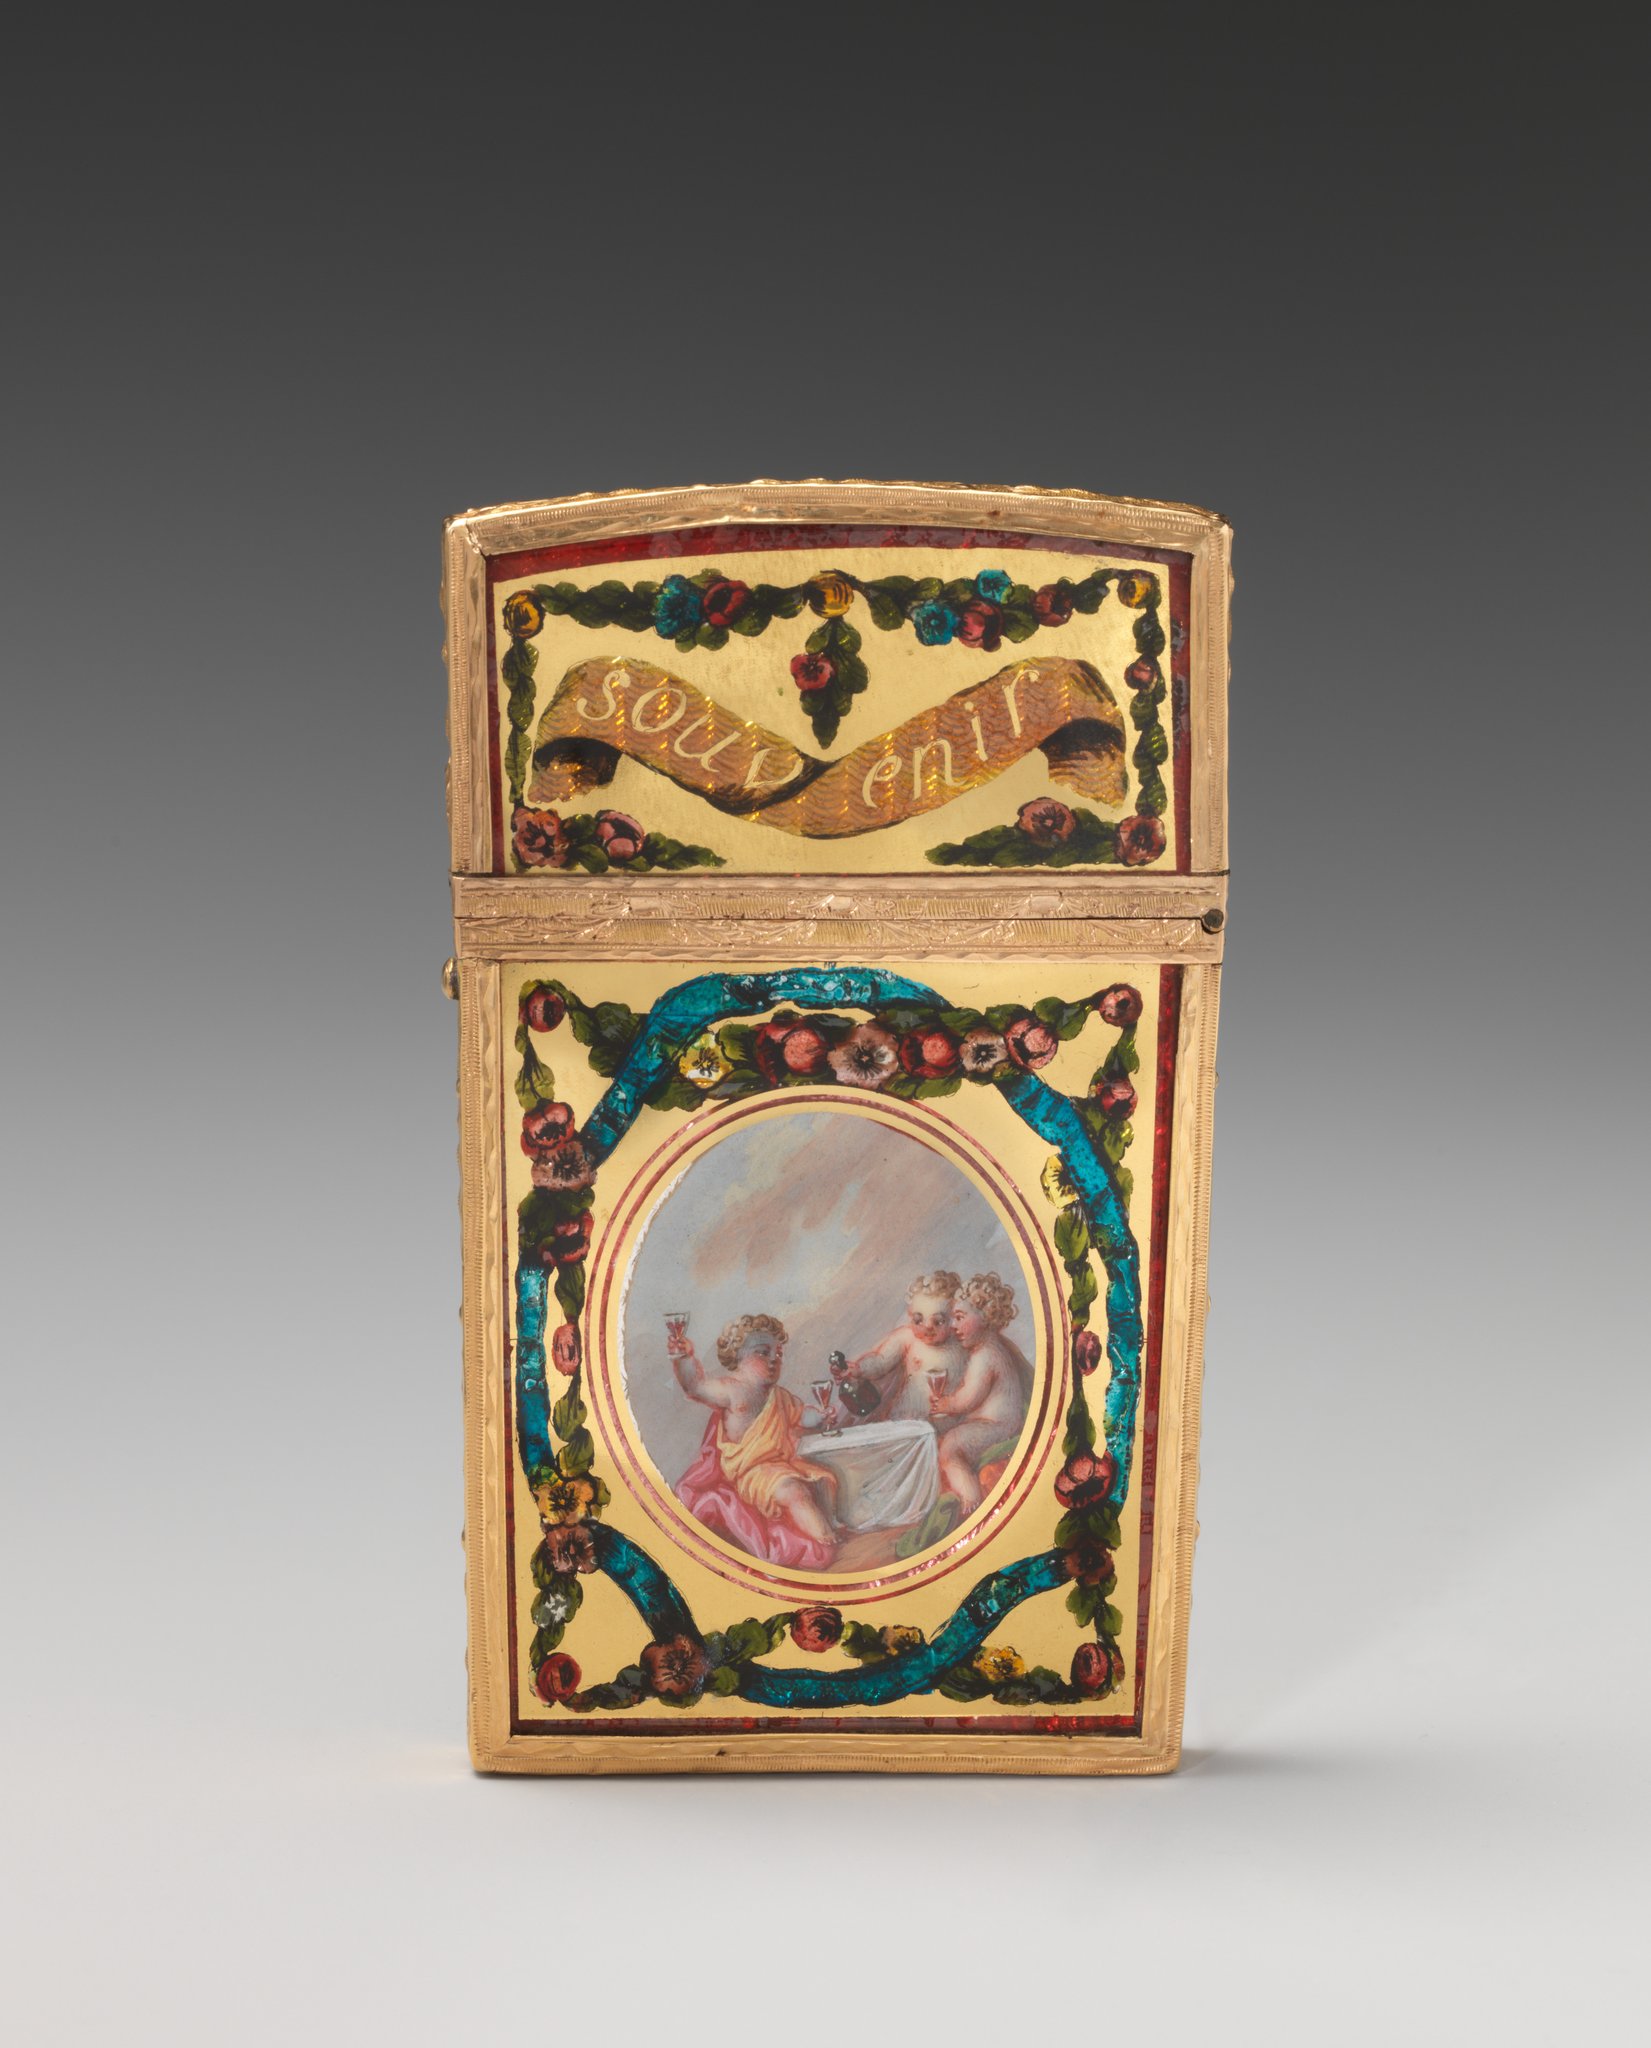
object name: souvenir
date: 1701-1900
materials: gold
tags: putti